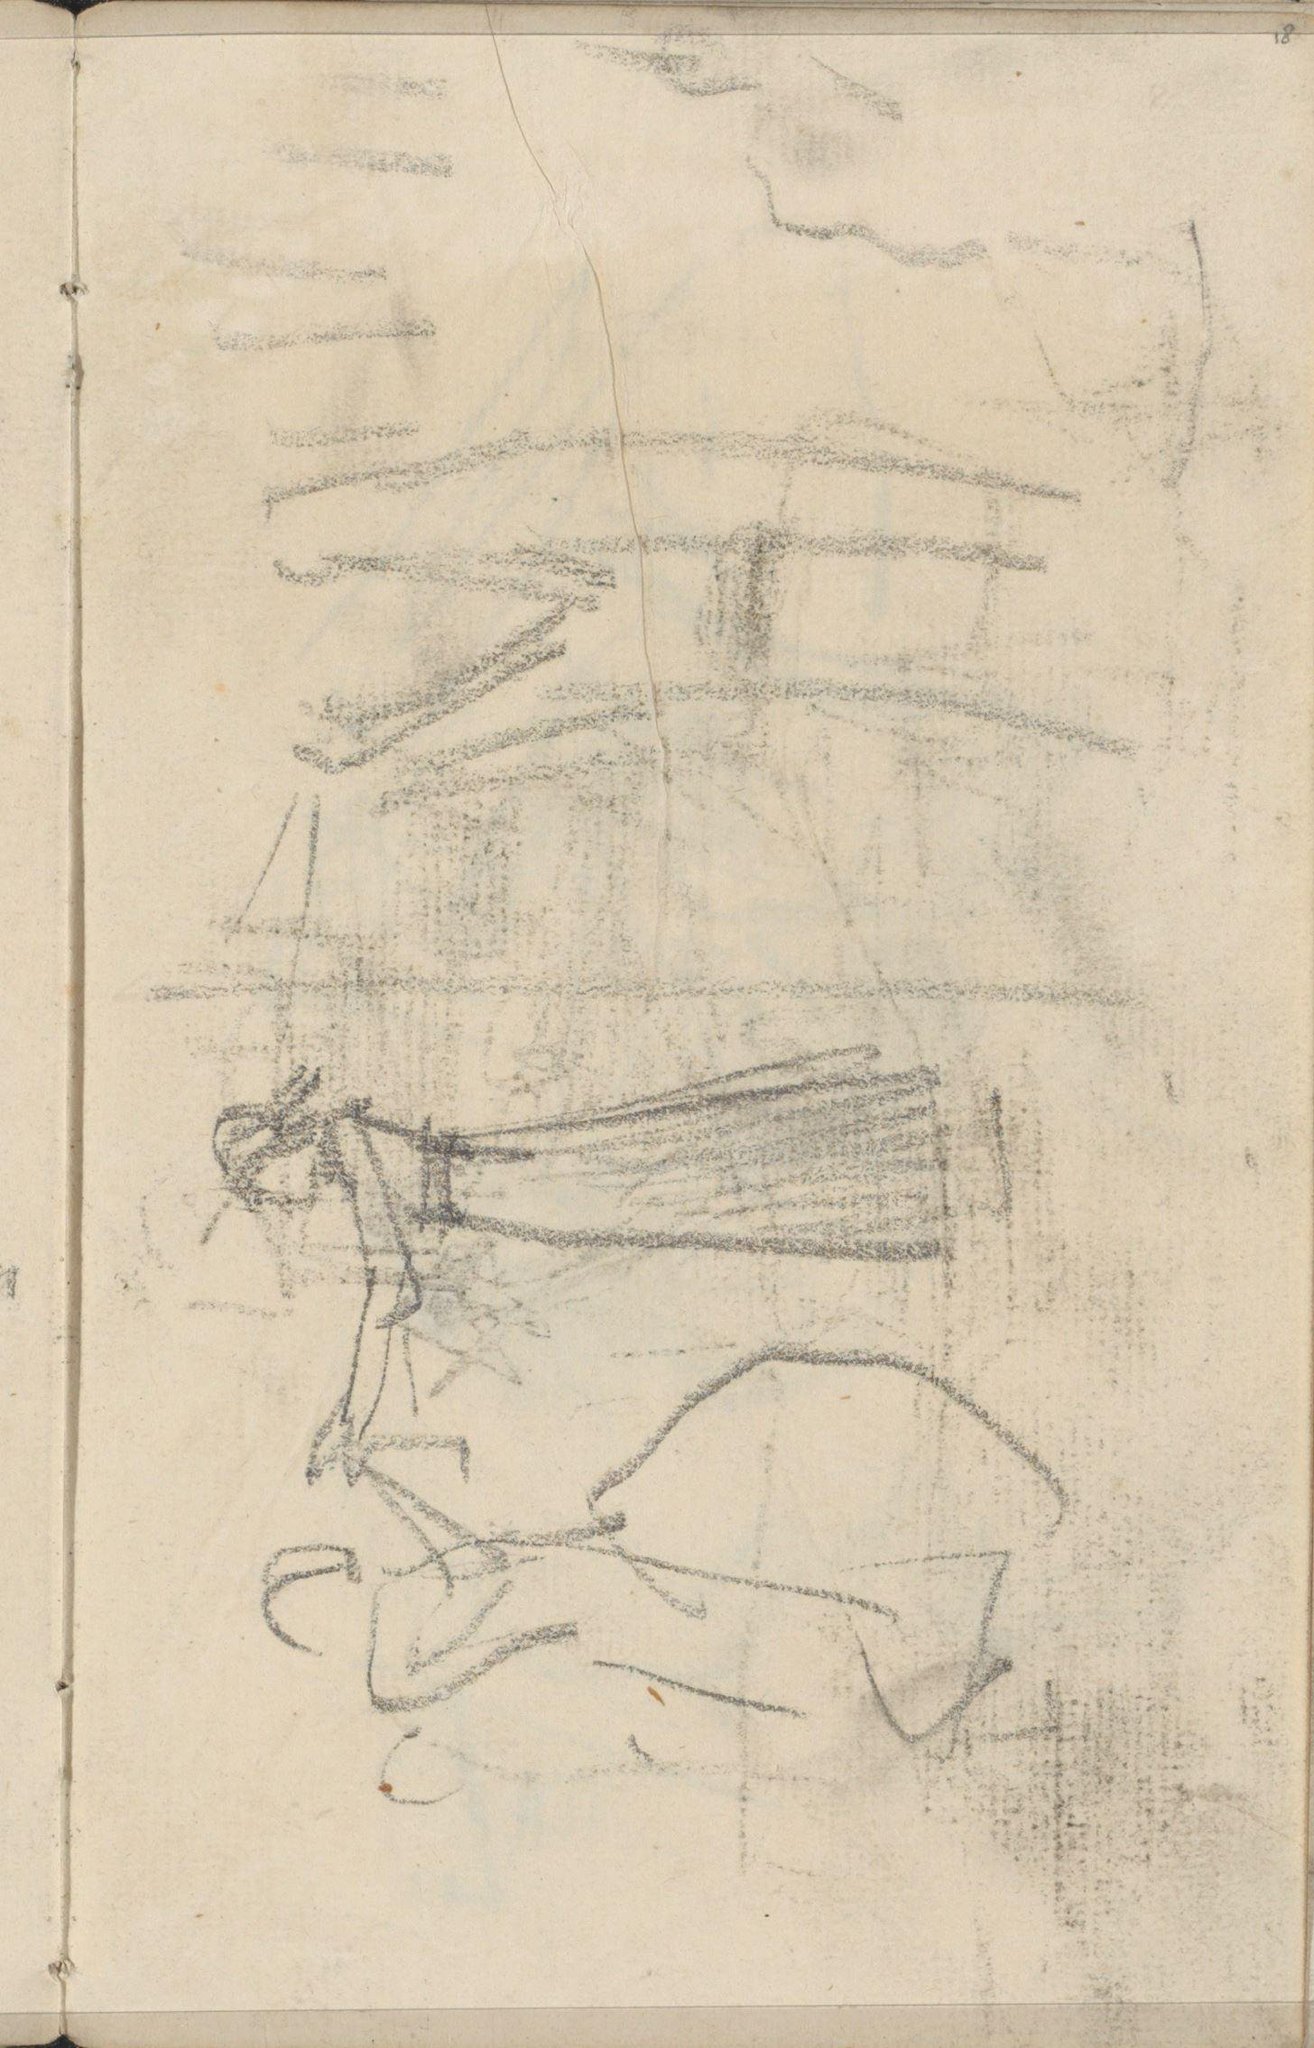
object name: sketchbook leaf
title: Twee vrouwen tegenover elkaar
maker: george hendrik breitner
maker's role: draughtsman, painter, print maker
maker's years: 1857-1923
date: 1884-1886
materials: chalk, paper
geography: paris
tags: standing figure - aa - female human figure (+ two persons)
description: Pagina 18 uit een schetsboek met 25 bladen.